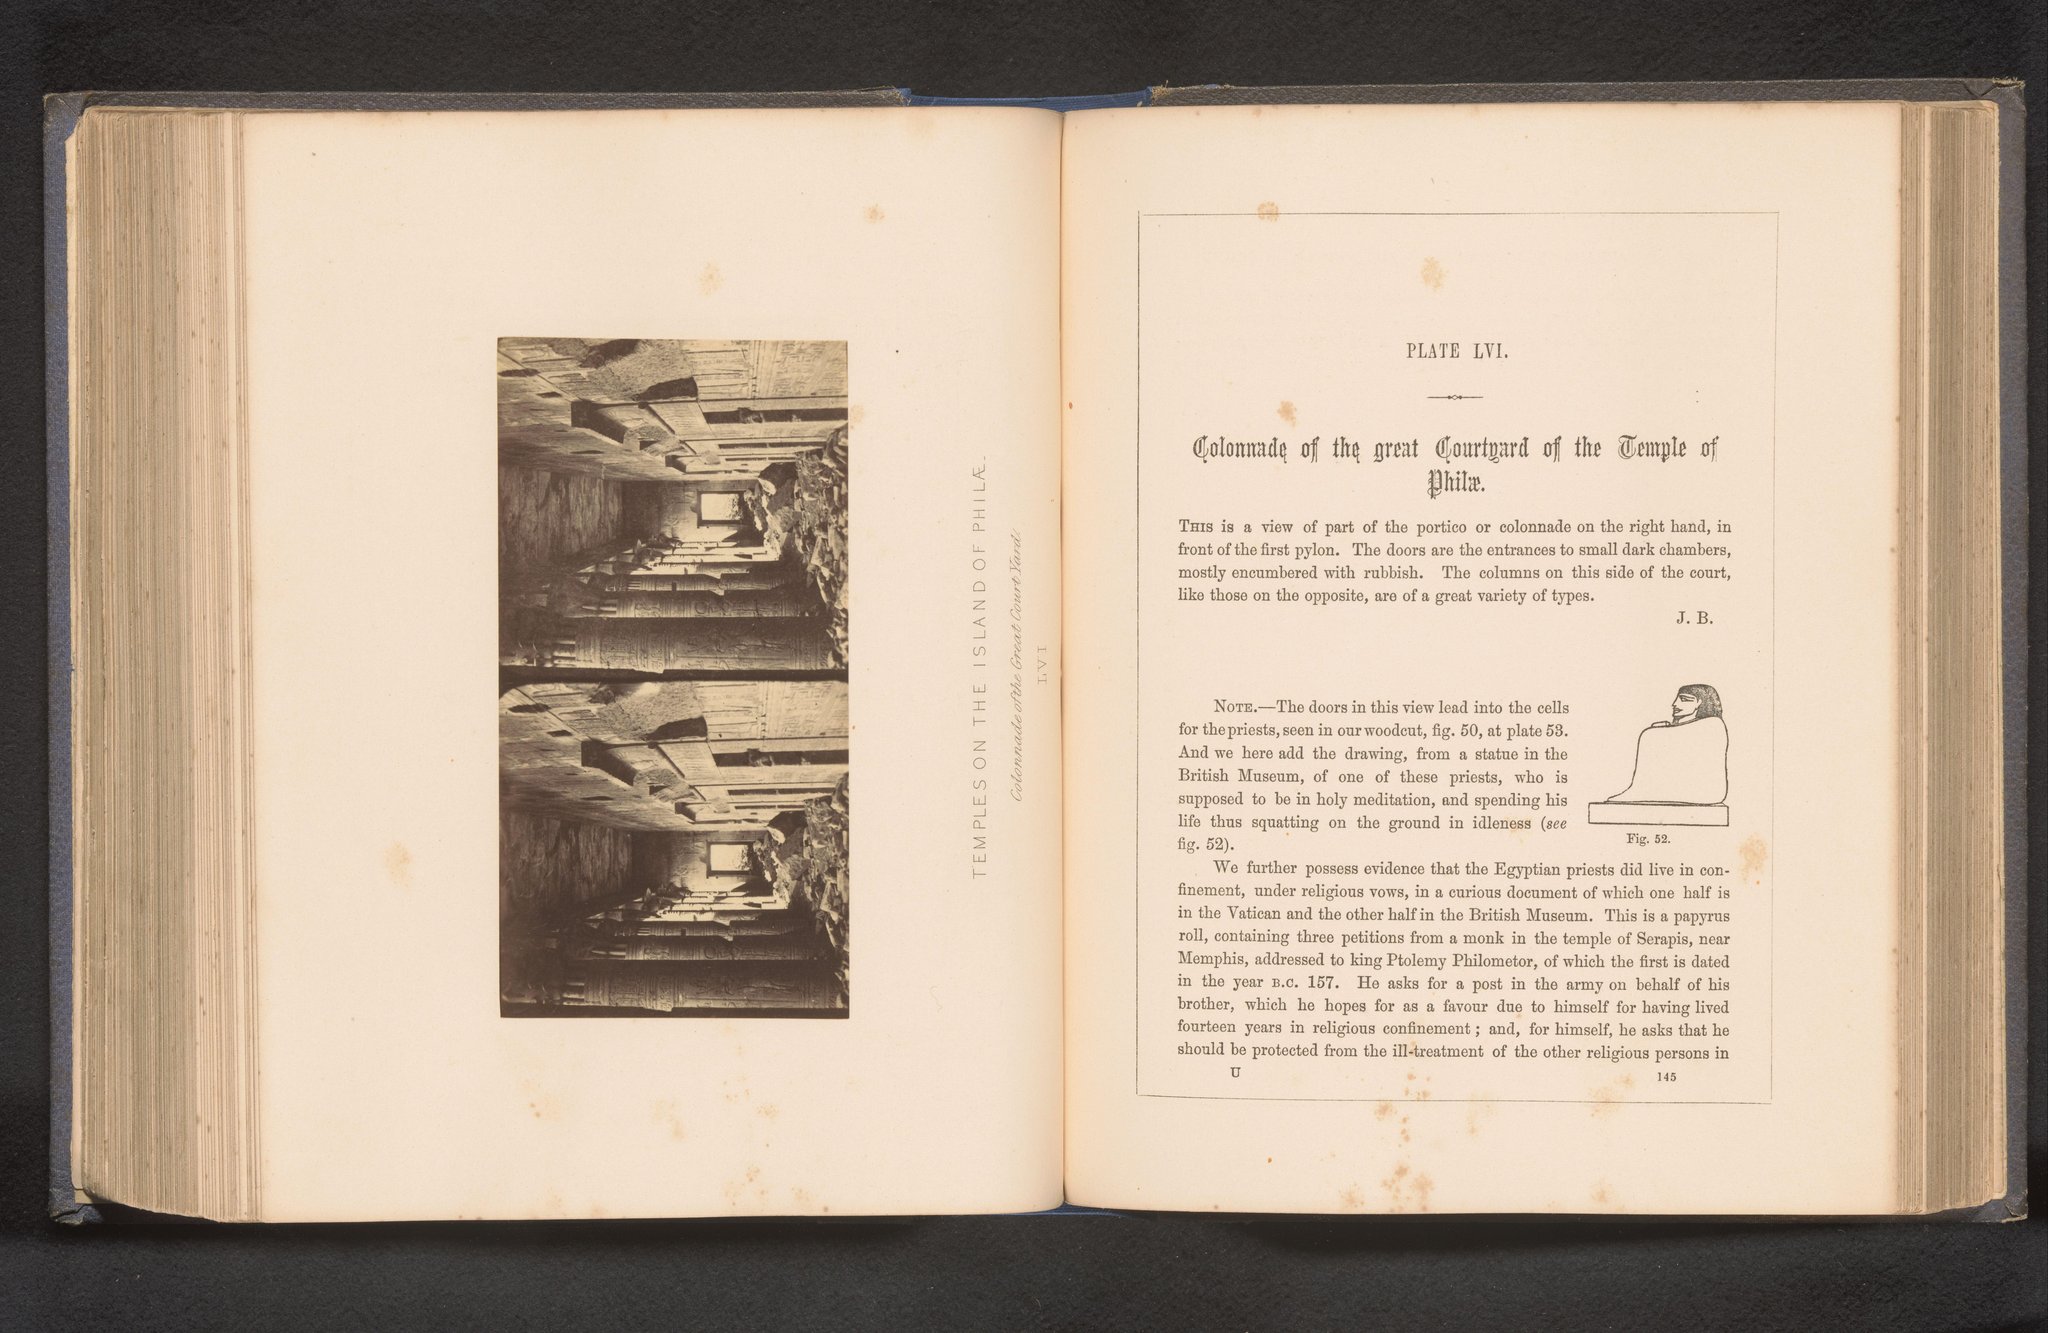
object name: page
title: Colonnade bij het tempelcomplex te Philae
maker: francis frith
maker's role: publisher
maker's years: 1822-1898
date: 1857-1862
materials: photographic support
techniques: albumen print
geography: philae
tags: temple, shrine ~ egyptian religion, colonnade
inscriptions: name: ‘Frith’, number: ‘LVI’, inscription: ‘Colonnade of the Great Court Yard’